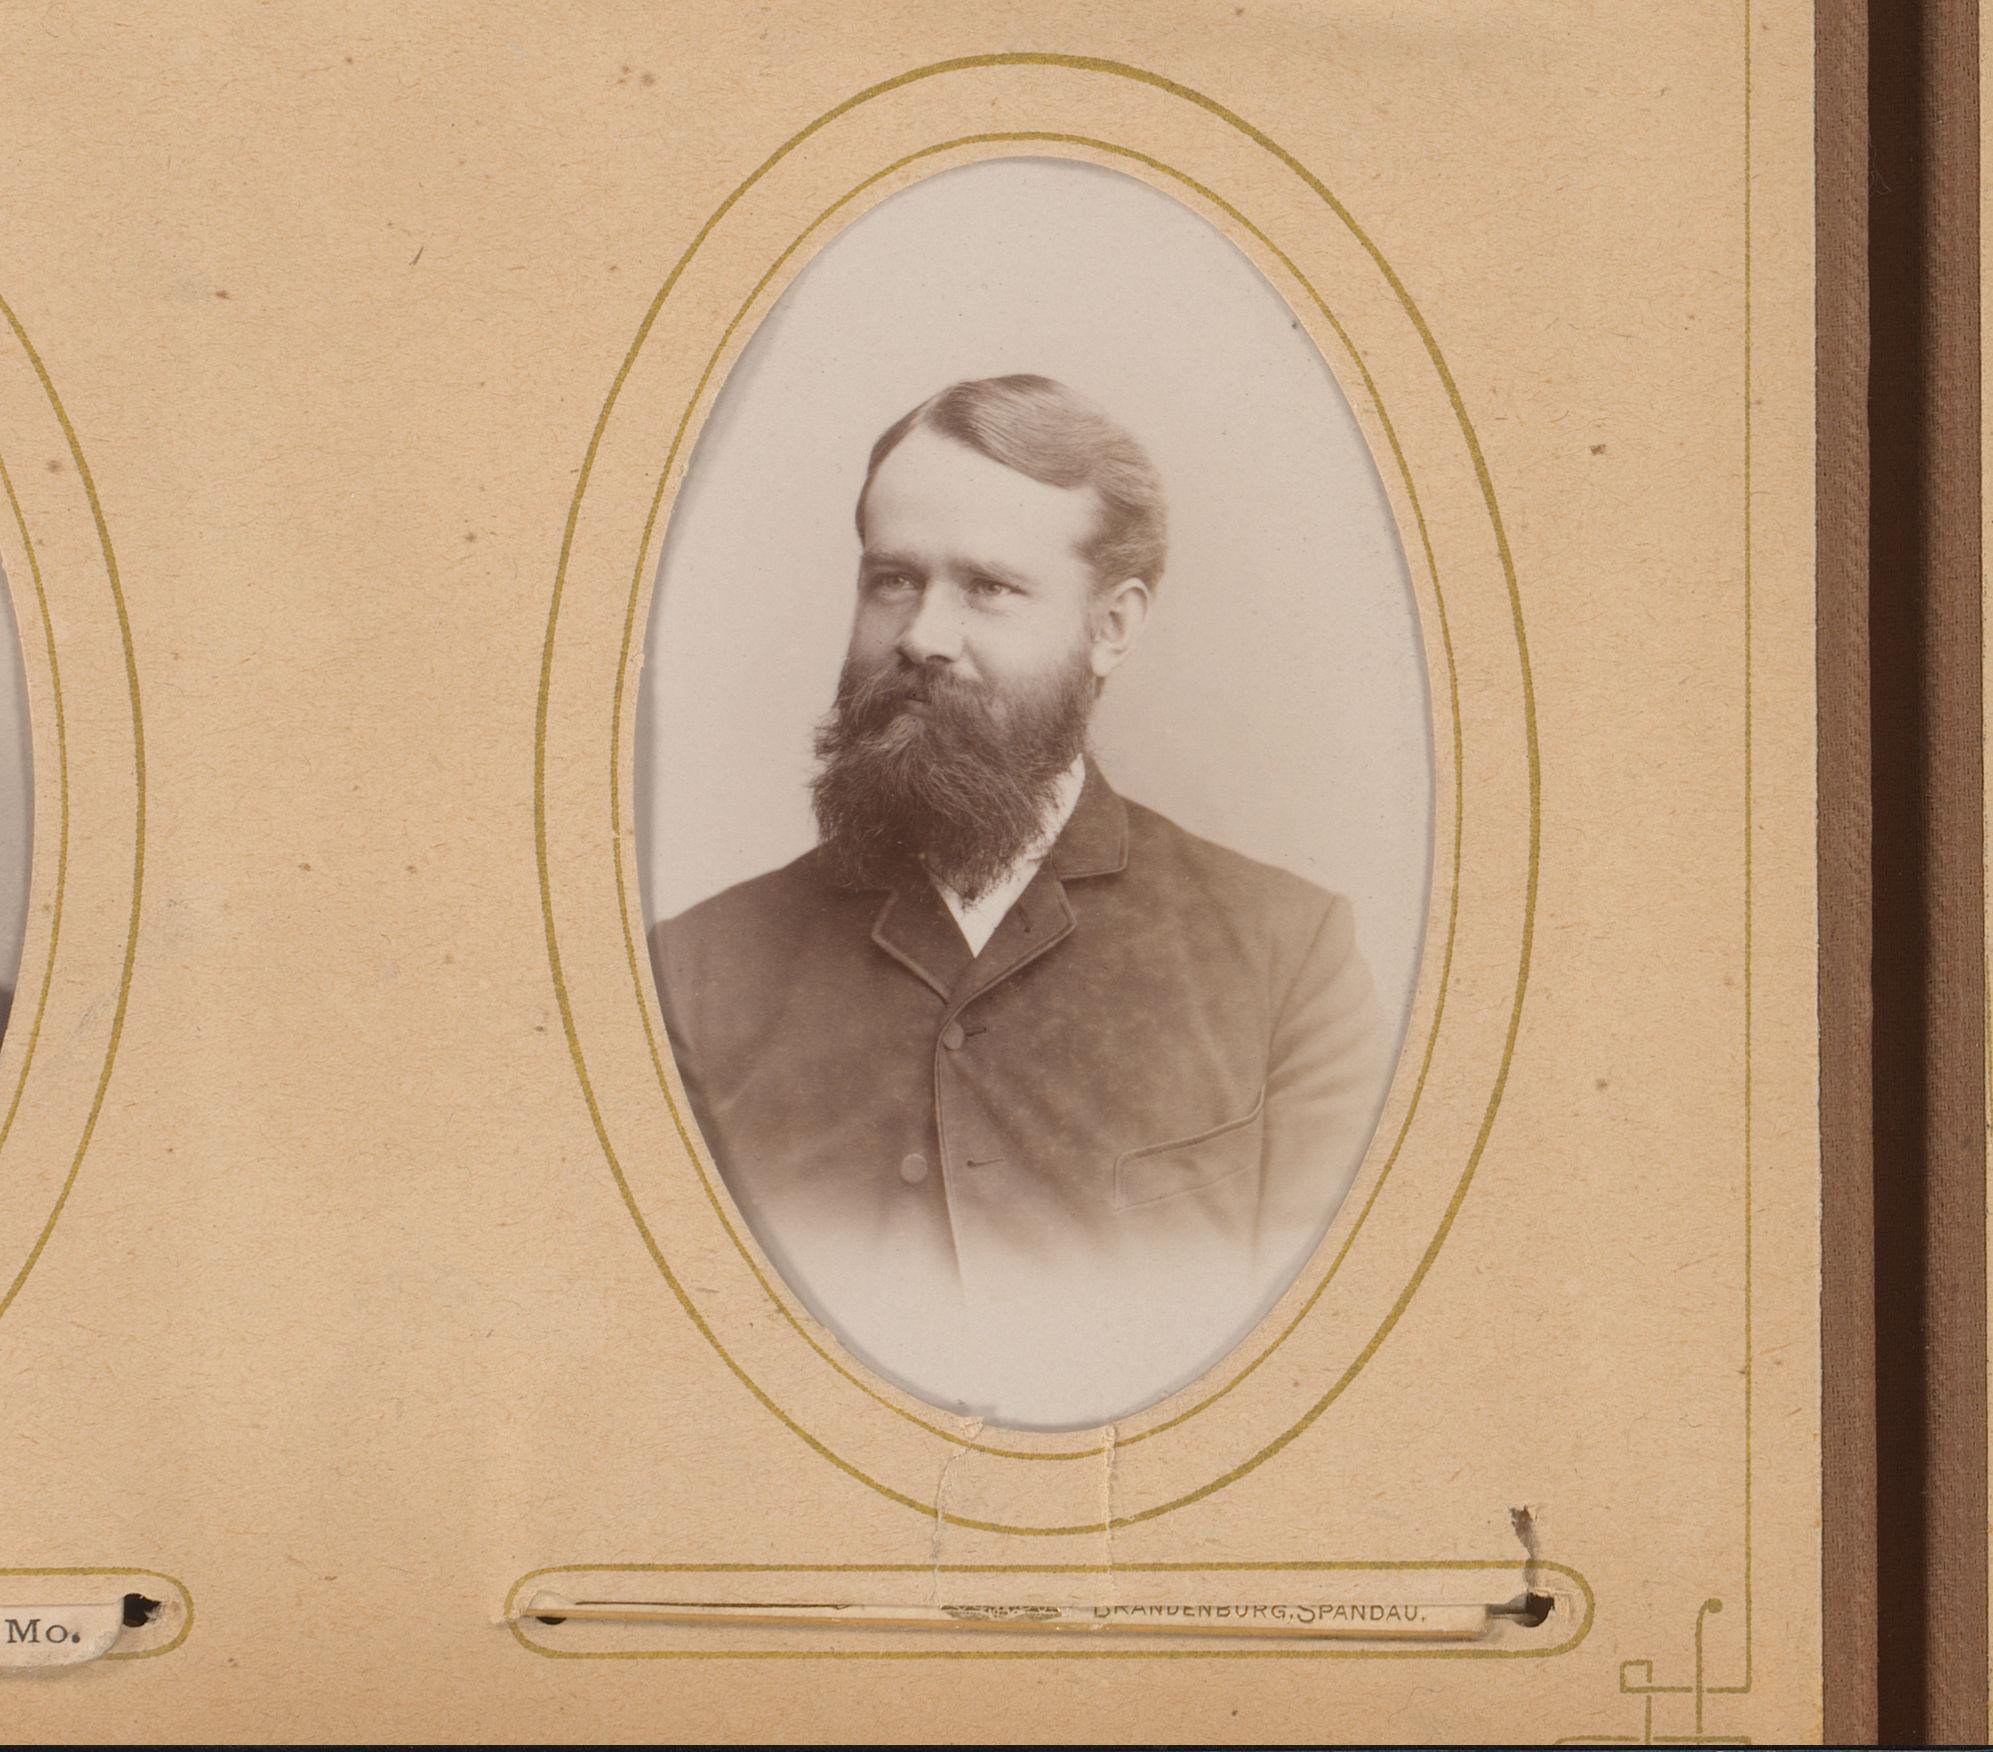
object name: photograph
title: Portret van een man met snor en baard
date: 1860-1900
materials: cardboard, photographic support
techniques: albumen print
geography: germany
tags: moustache, historical persons, beard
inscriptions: inscription: ‘SELLE & KUNTZE/ HOF-PHOTOGRAPHEN/ SR. MAJ. DES KAISERS UND KÖNIGS./ POTSDAM/ Schwertfegerstr. No 14./ BRANDENBURG a/H./ Haupstr. No. 16, im Garten./ SPANDAU/ Havelstr. No. 2./ Fernsprech-Anschluss in Potsdam No 137./ Die Platte bleibt für Nachbestellungen aufbewahrt.’